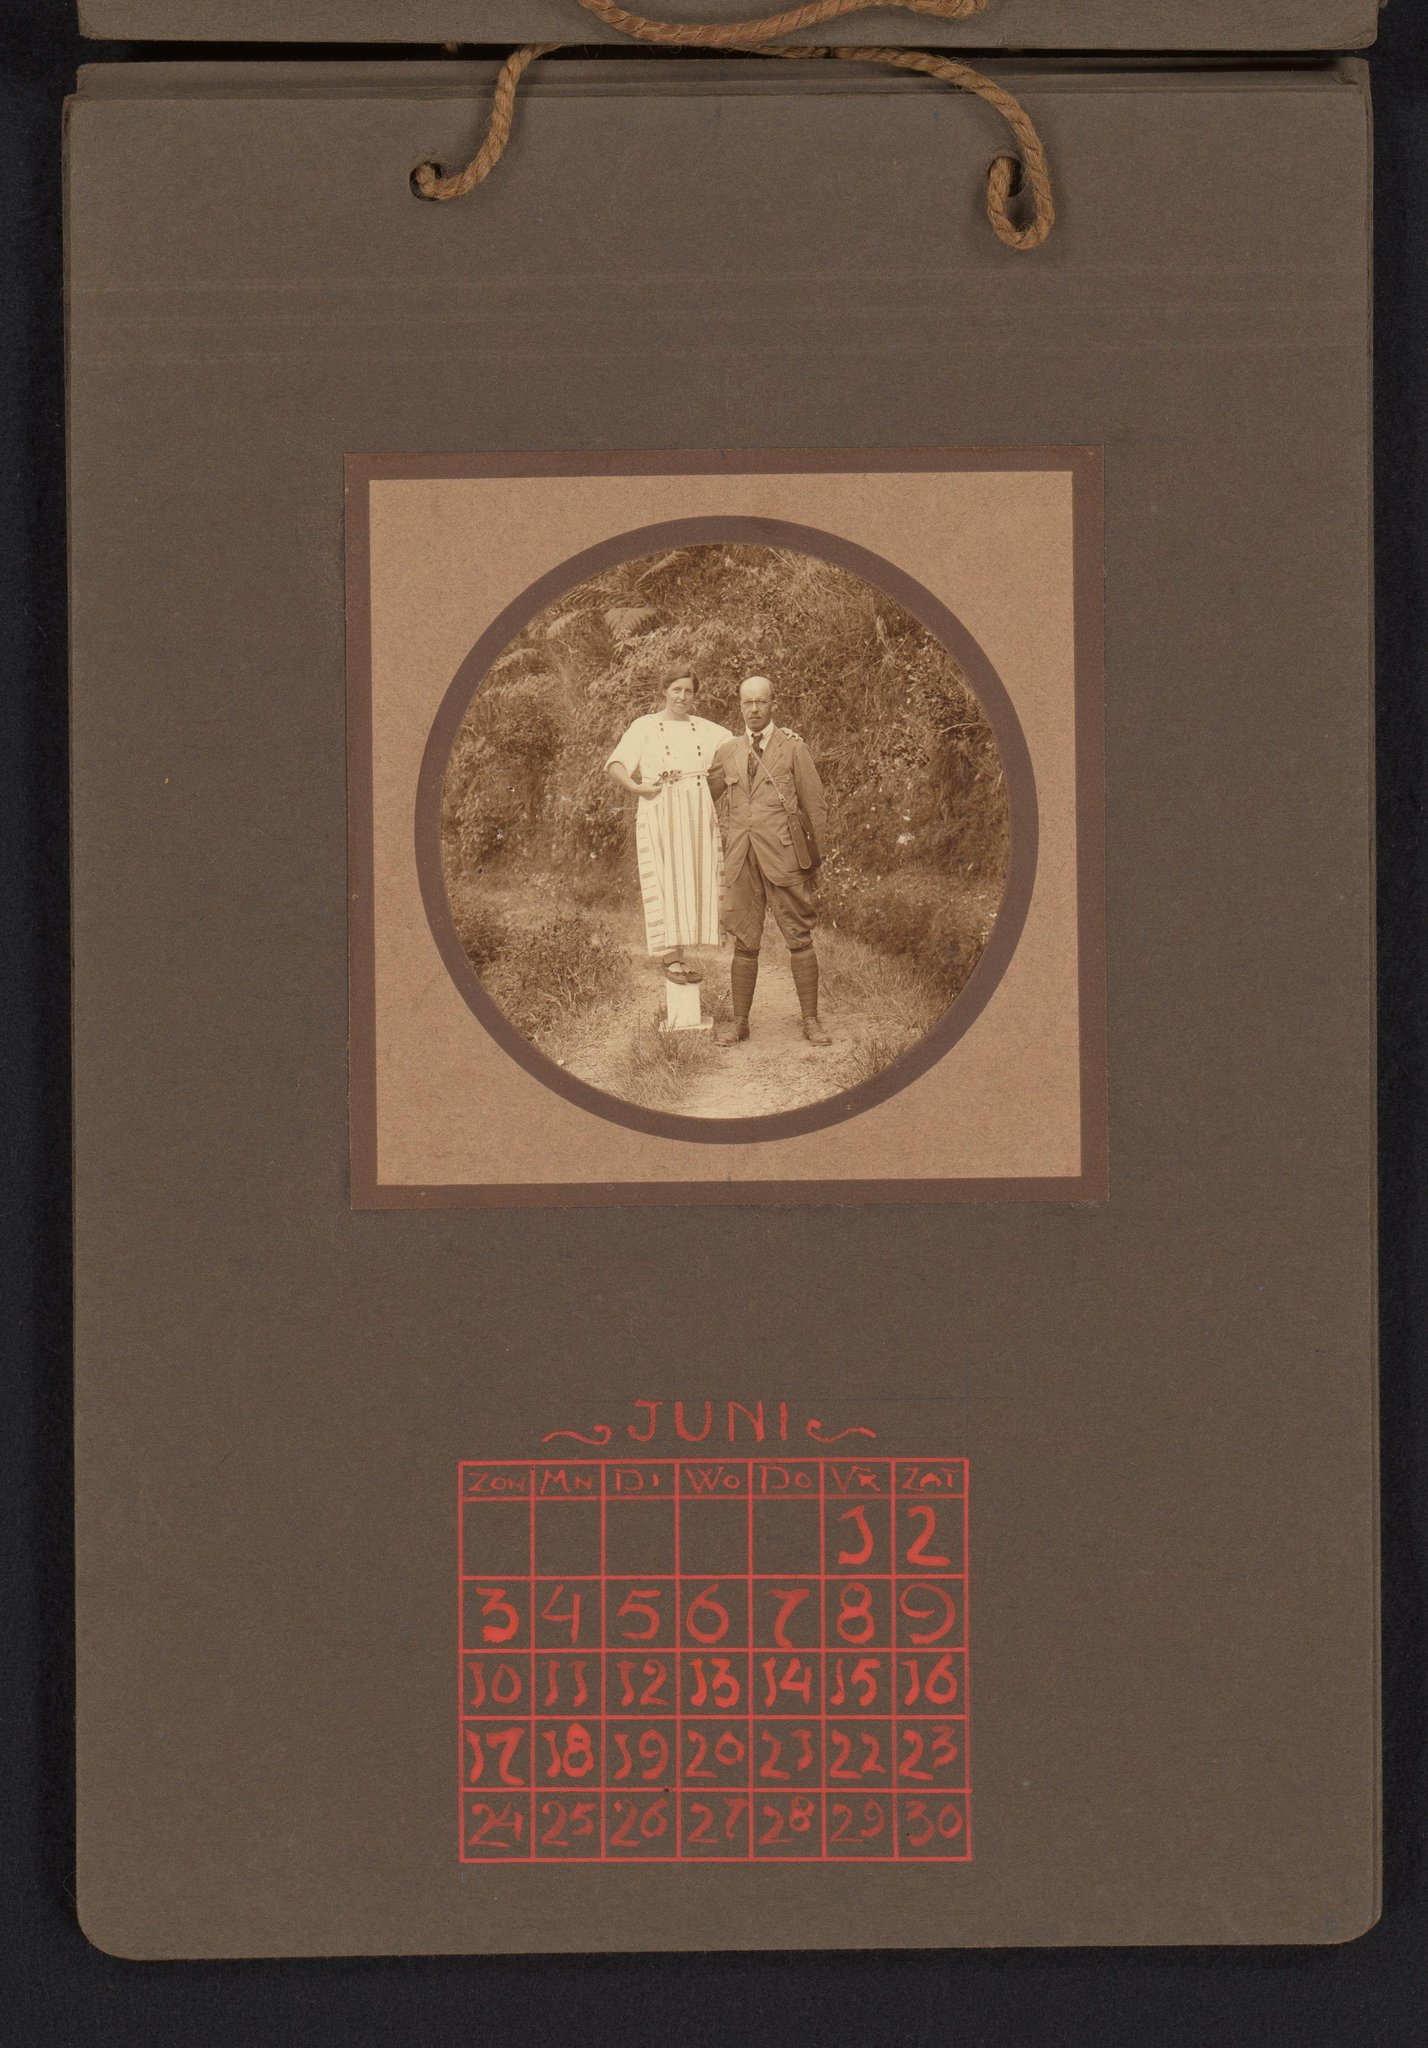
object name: photograph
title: Portret van een echtpaar in een natuurrijke omgeving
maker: Anonymous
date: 1880-1923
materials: cardboard, paper, photographic support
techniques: collodion silver print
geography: indonesia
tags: historical persons - bb - woman, historical persons, marriage, married couple, 'matrimonium', indonesia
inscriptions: annotation: ‘JUNI/ (...)’